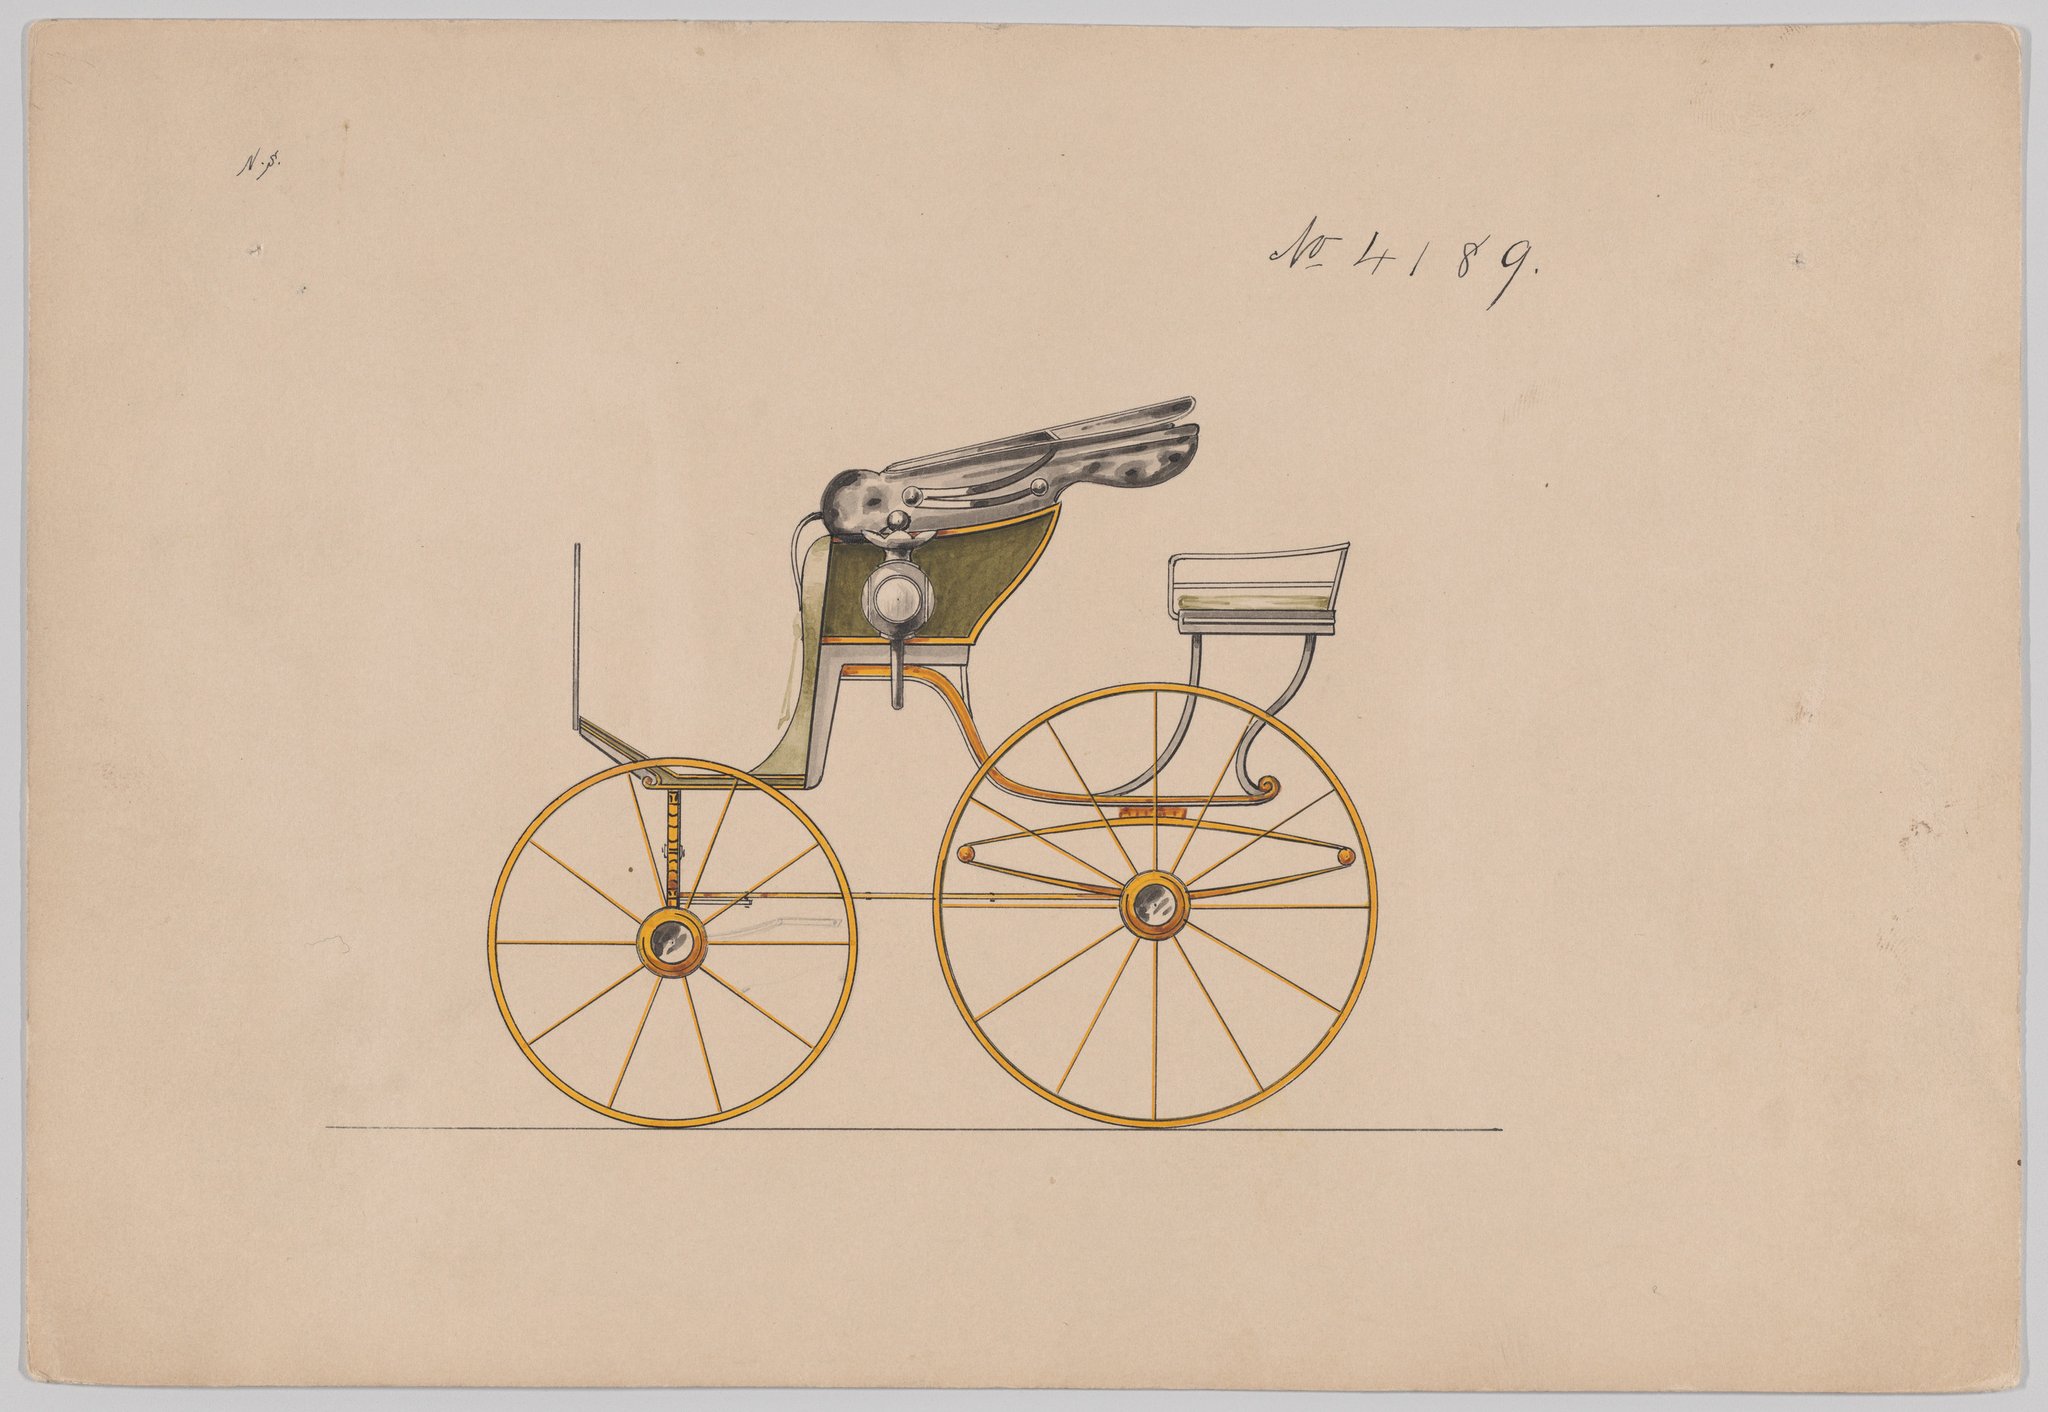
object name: drawing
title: Design for Pony Phaeton, no. 4189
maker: brewster & co.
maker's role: manufacturer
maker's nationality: american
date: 1892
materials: gouache, ink, watercolor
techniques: pen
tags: carriages